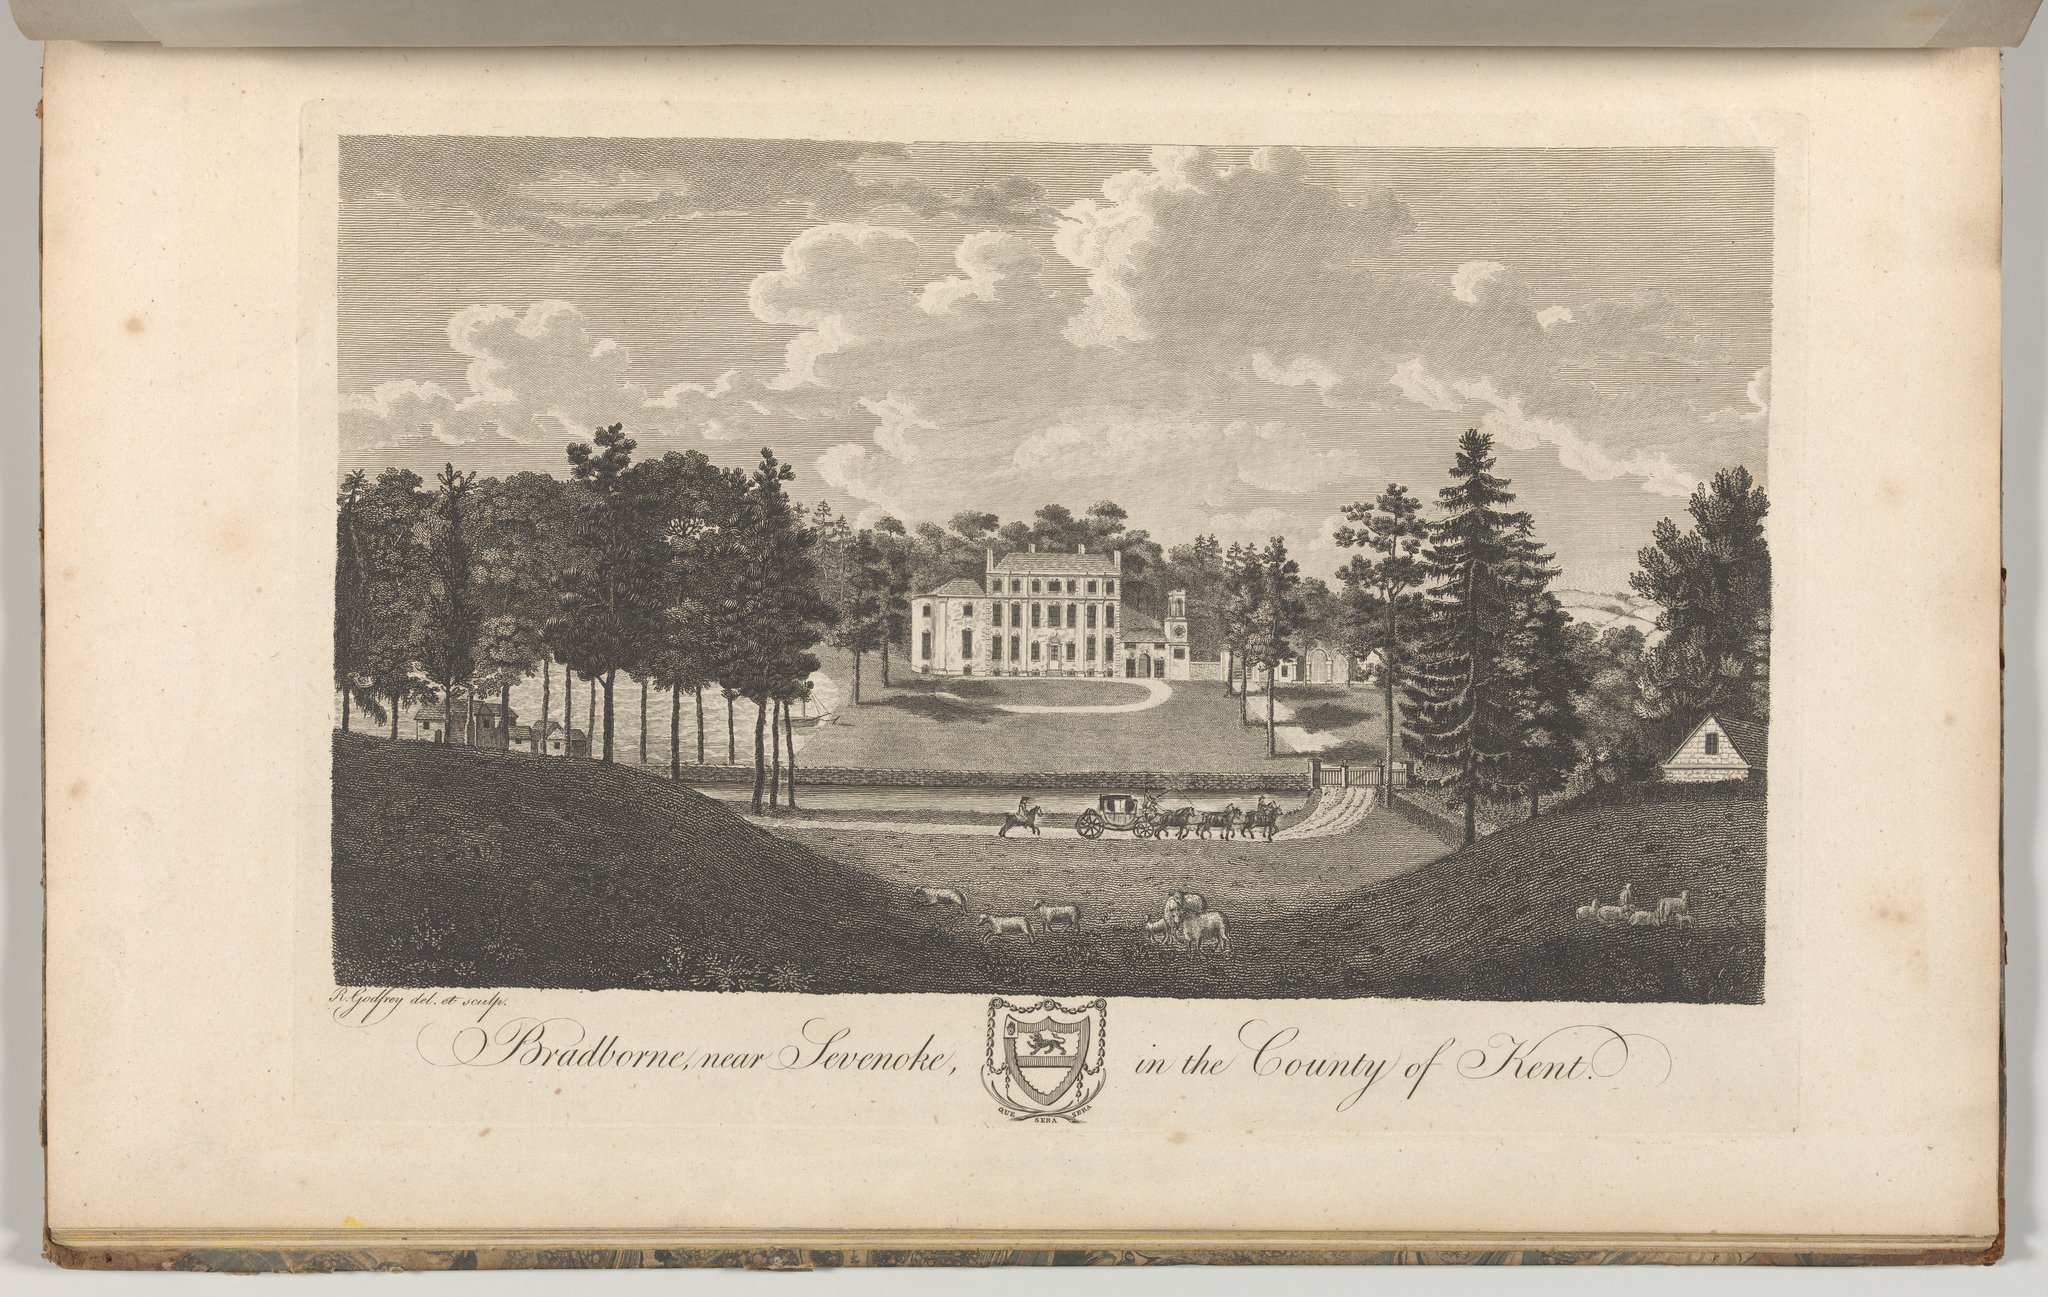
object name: print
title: Bradborne, near Sevenoke, in the County of Kent, from Edward Hasted's "The History and Topographical Survey of the County of Kent", vols. 1-3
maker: richard bernard godfrey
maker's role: artist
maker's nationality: british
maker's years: 1728-1795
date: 1777-1790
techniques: engraving, etching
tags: buildings,trees,coat of arms